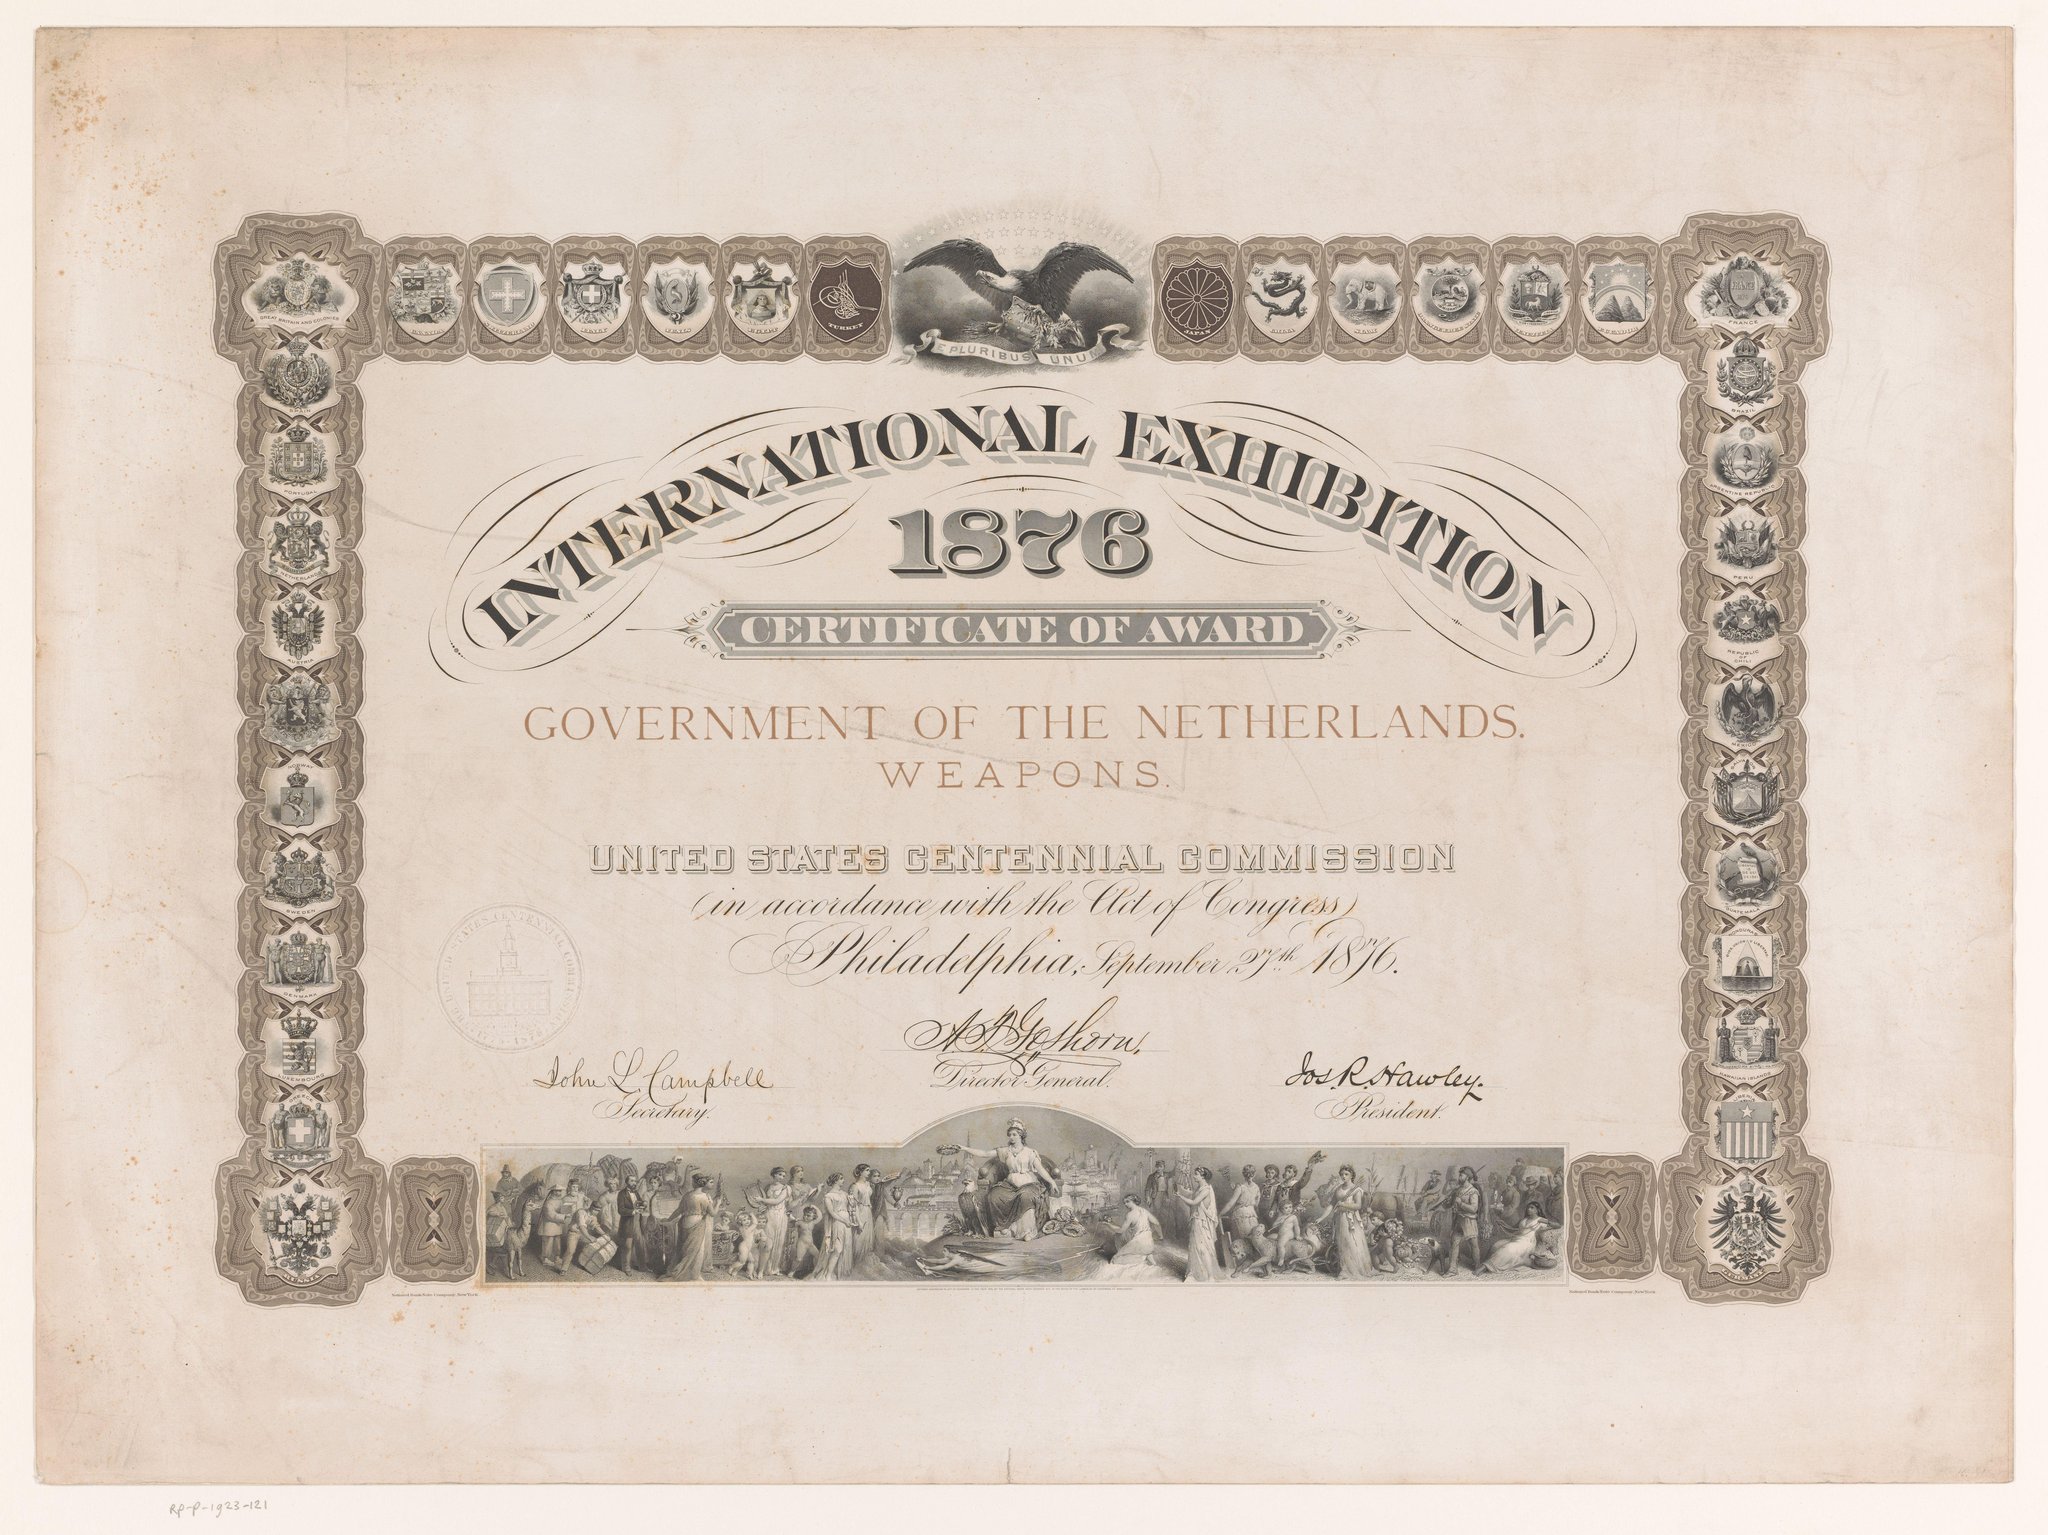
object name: certificate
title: International Exhibition, 1876, Certificate of Award, Government of the Netherlands. Weapons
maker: Anonymous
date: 1876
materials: paper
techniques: etching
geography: england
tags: politician, coat of arms (as symbol of the state, etc.), predatory birds: eagle, the muses acting together (as group), crowning with laurel, trunked animals: elephant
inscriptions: signature: ‘John L. Campbell’, check stamp: ‘The United States Centennial Commission 1776-1876’, signature: ‘Jos. R. Hawley’, signature: ‘A.T. Goshorn’, collector's mark: Lugt 2233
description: Rondom het certificaat de wapenschilden van de deelnemende landen. Onder het certificaat een voorstelling waar centraal een vrouwelijke personificatie troont, vermoedelijk Columbia. Zij deelt lauwerkransen uit. Naast haar zit de rijksadelaar. Links en rechts van haar staan muzen en bezoekers uit verschillende landen.